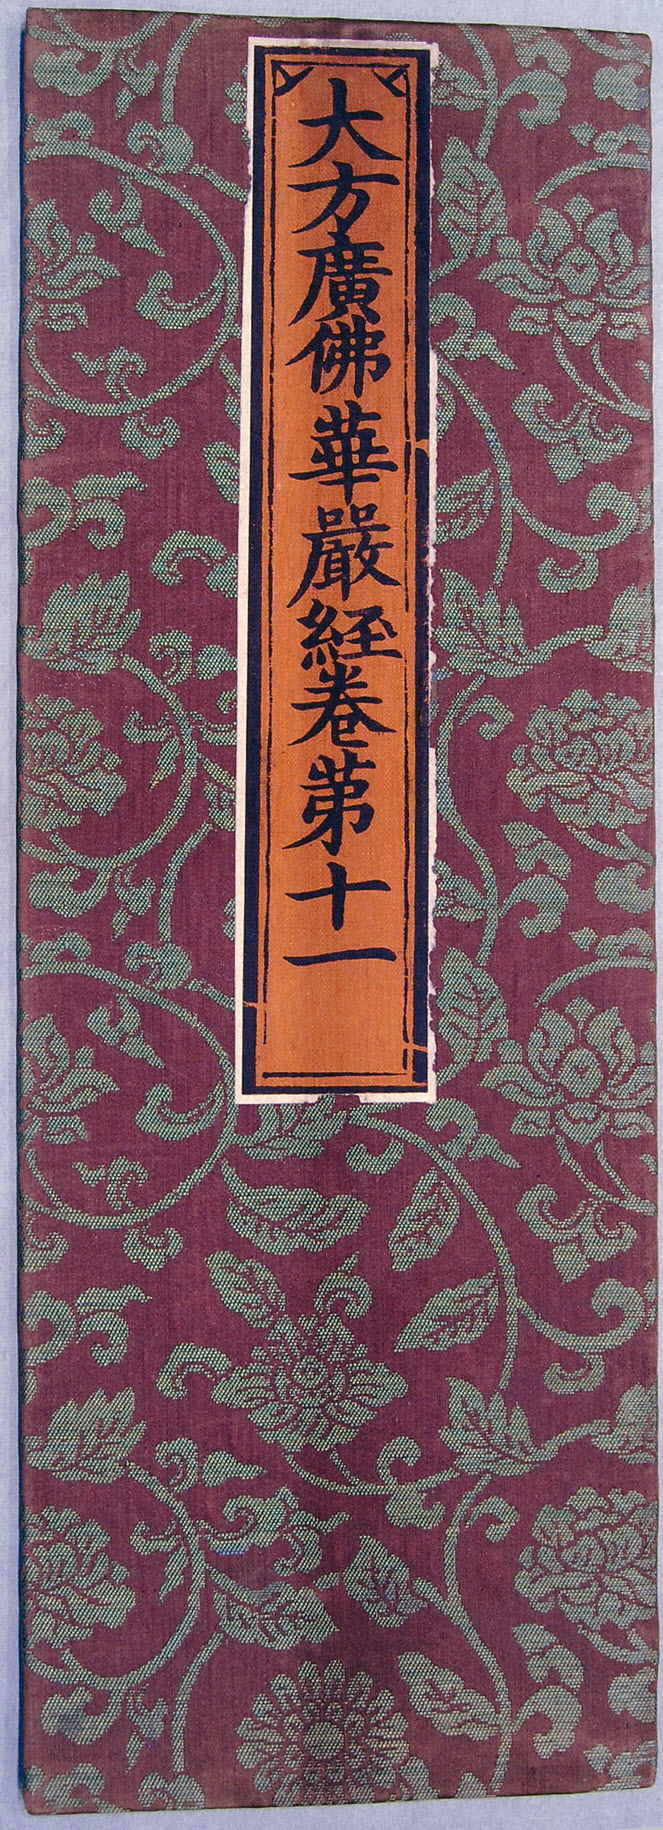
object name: sutra cover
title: Sutra Cover with Pattern of Various Flowers with Leaves and Scrolling Stems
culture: chinese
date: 1501-1600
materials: silk